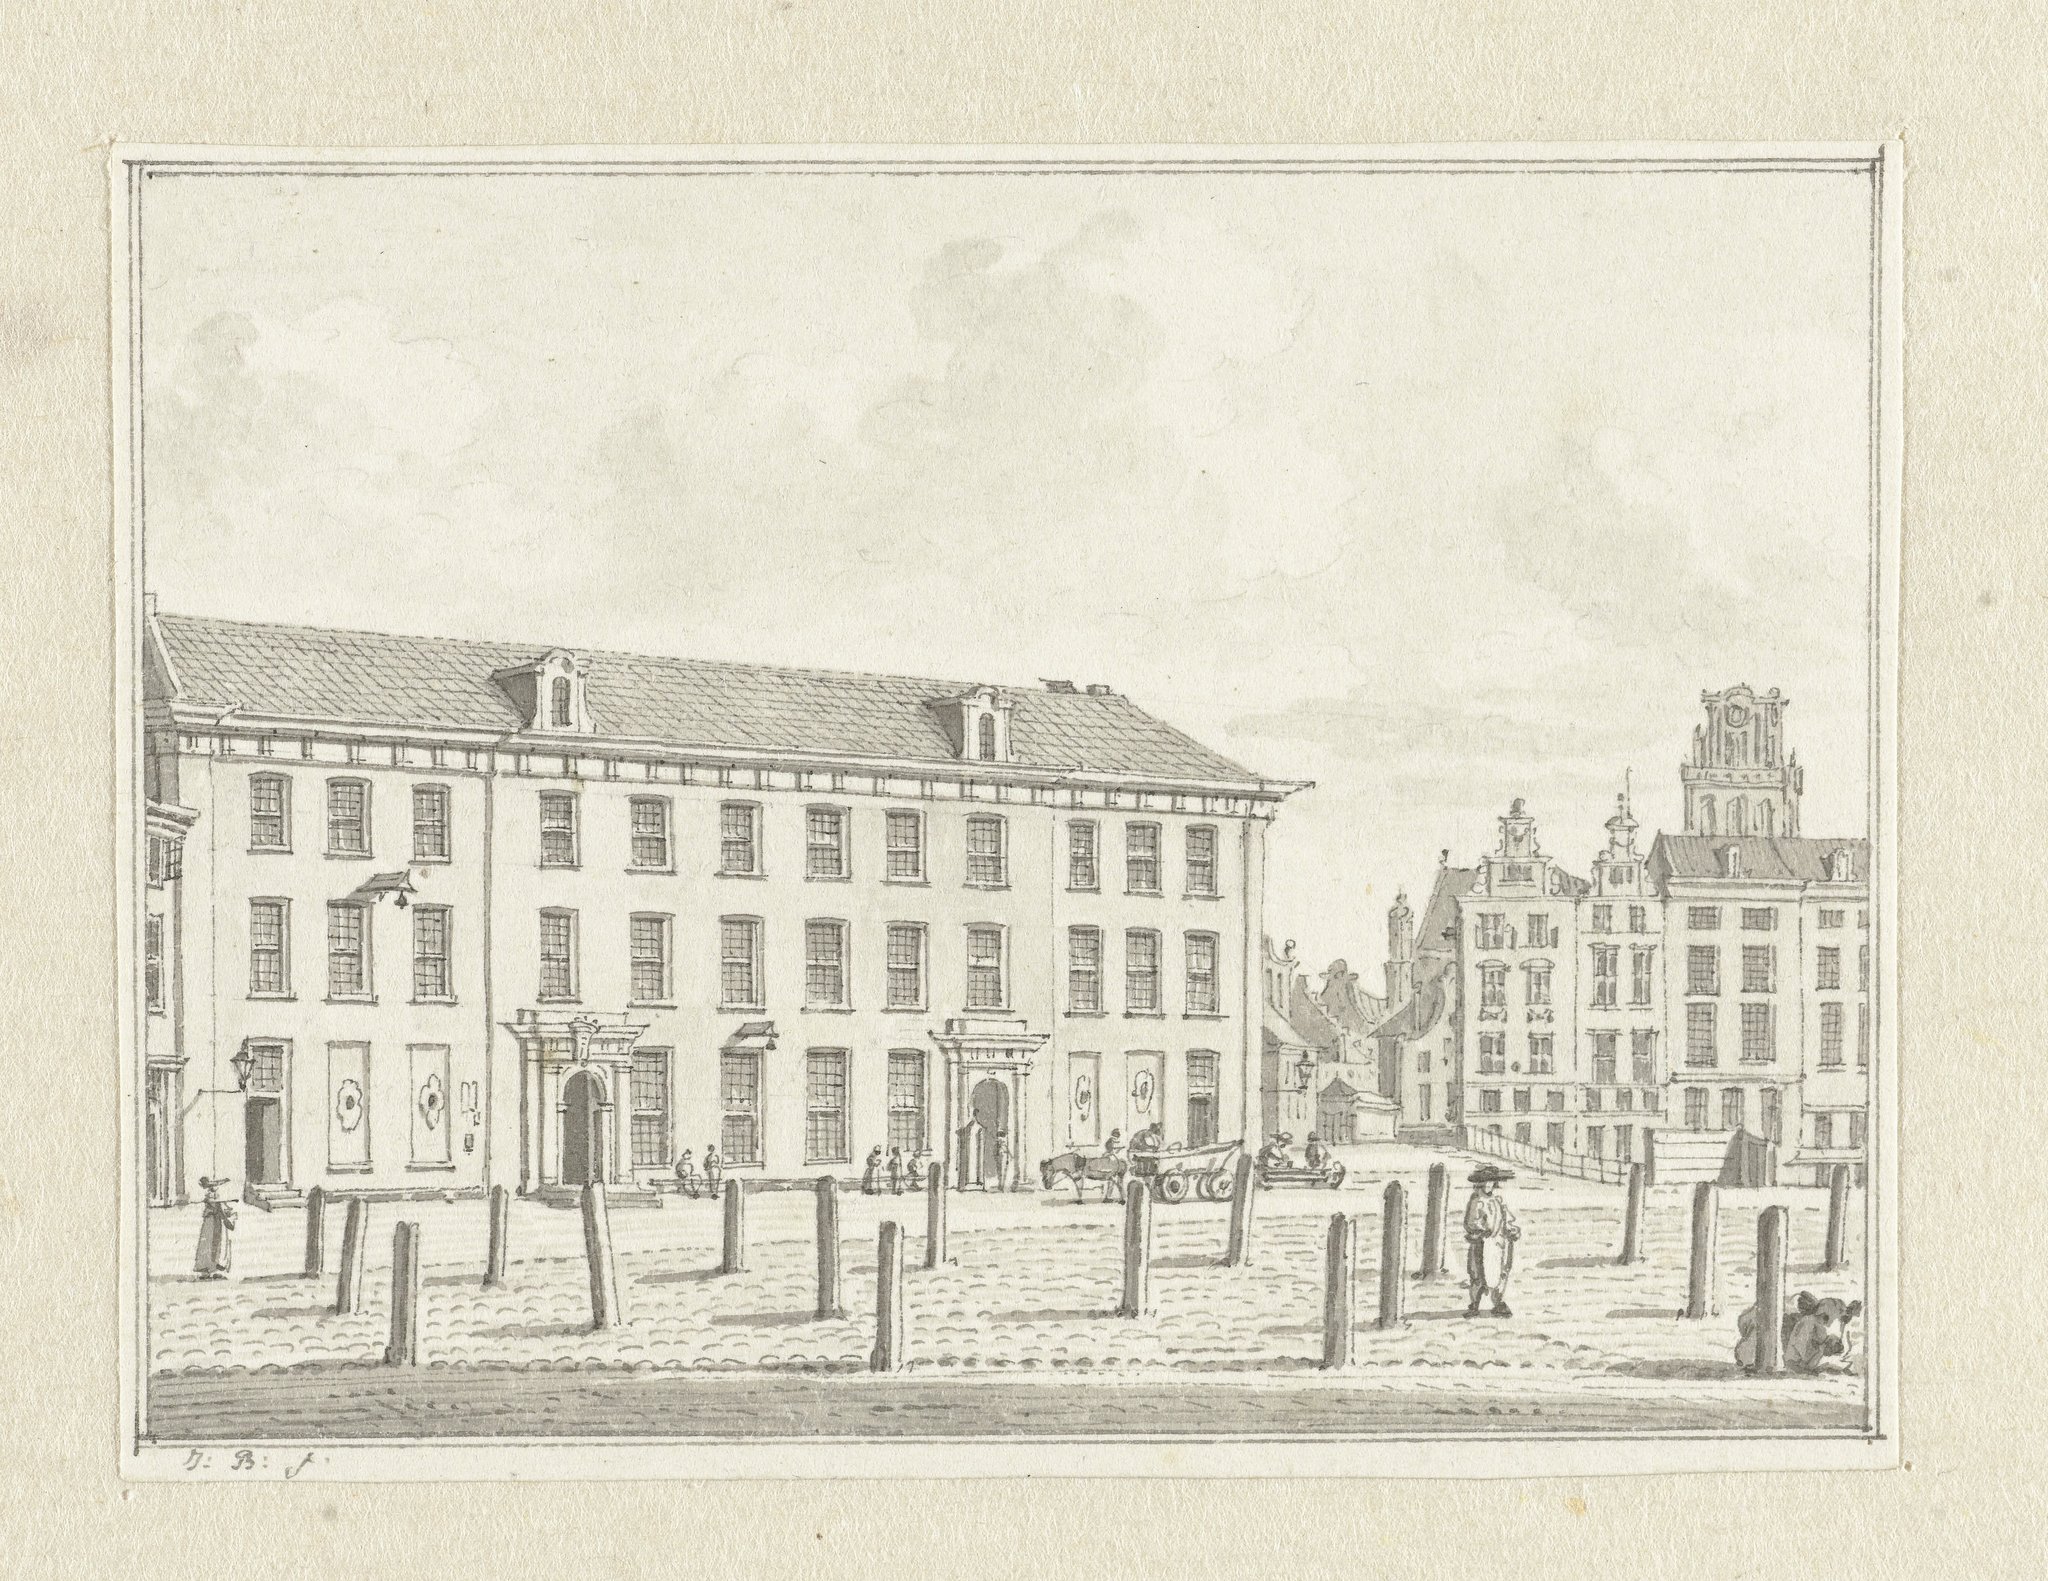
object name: drawing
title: Zakkendragershuis te Rotterdam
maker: jan bulthuis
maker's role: draughtsman, print maker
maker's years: 1750-1801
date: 1790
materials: ink, paper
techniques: brush, pen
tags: city-view, and landscape with man-made constructions, rotterdam